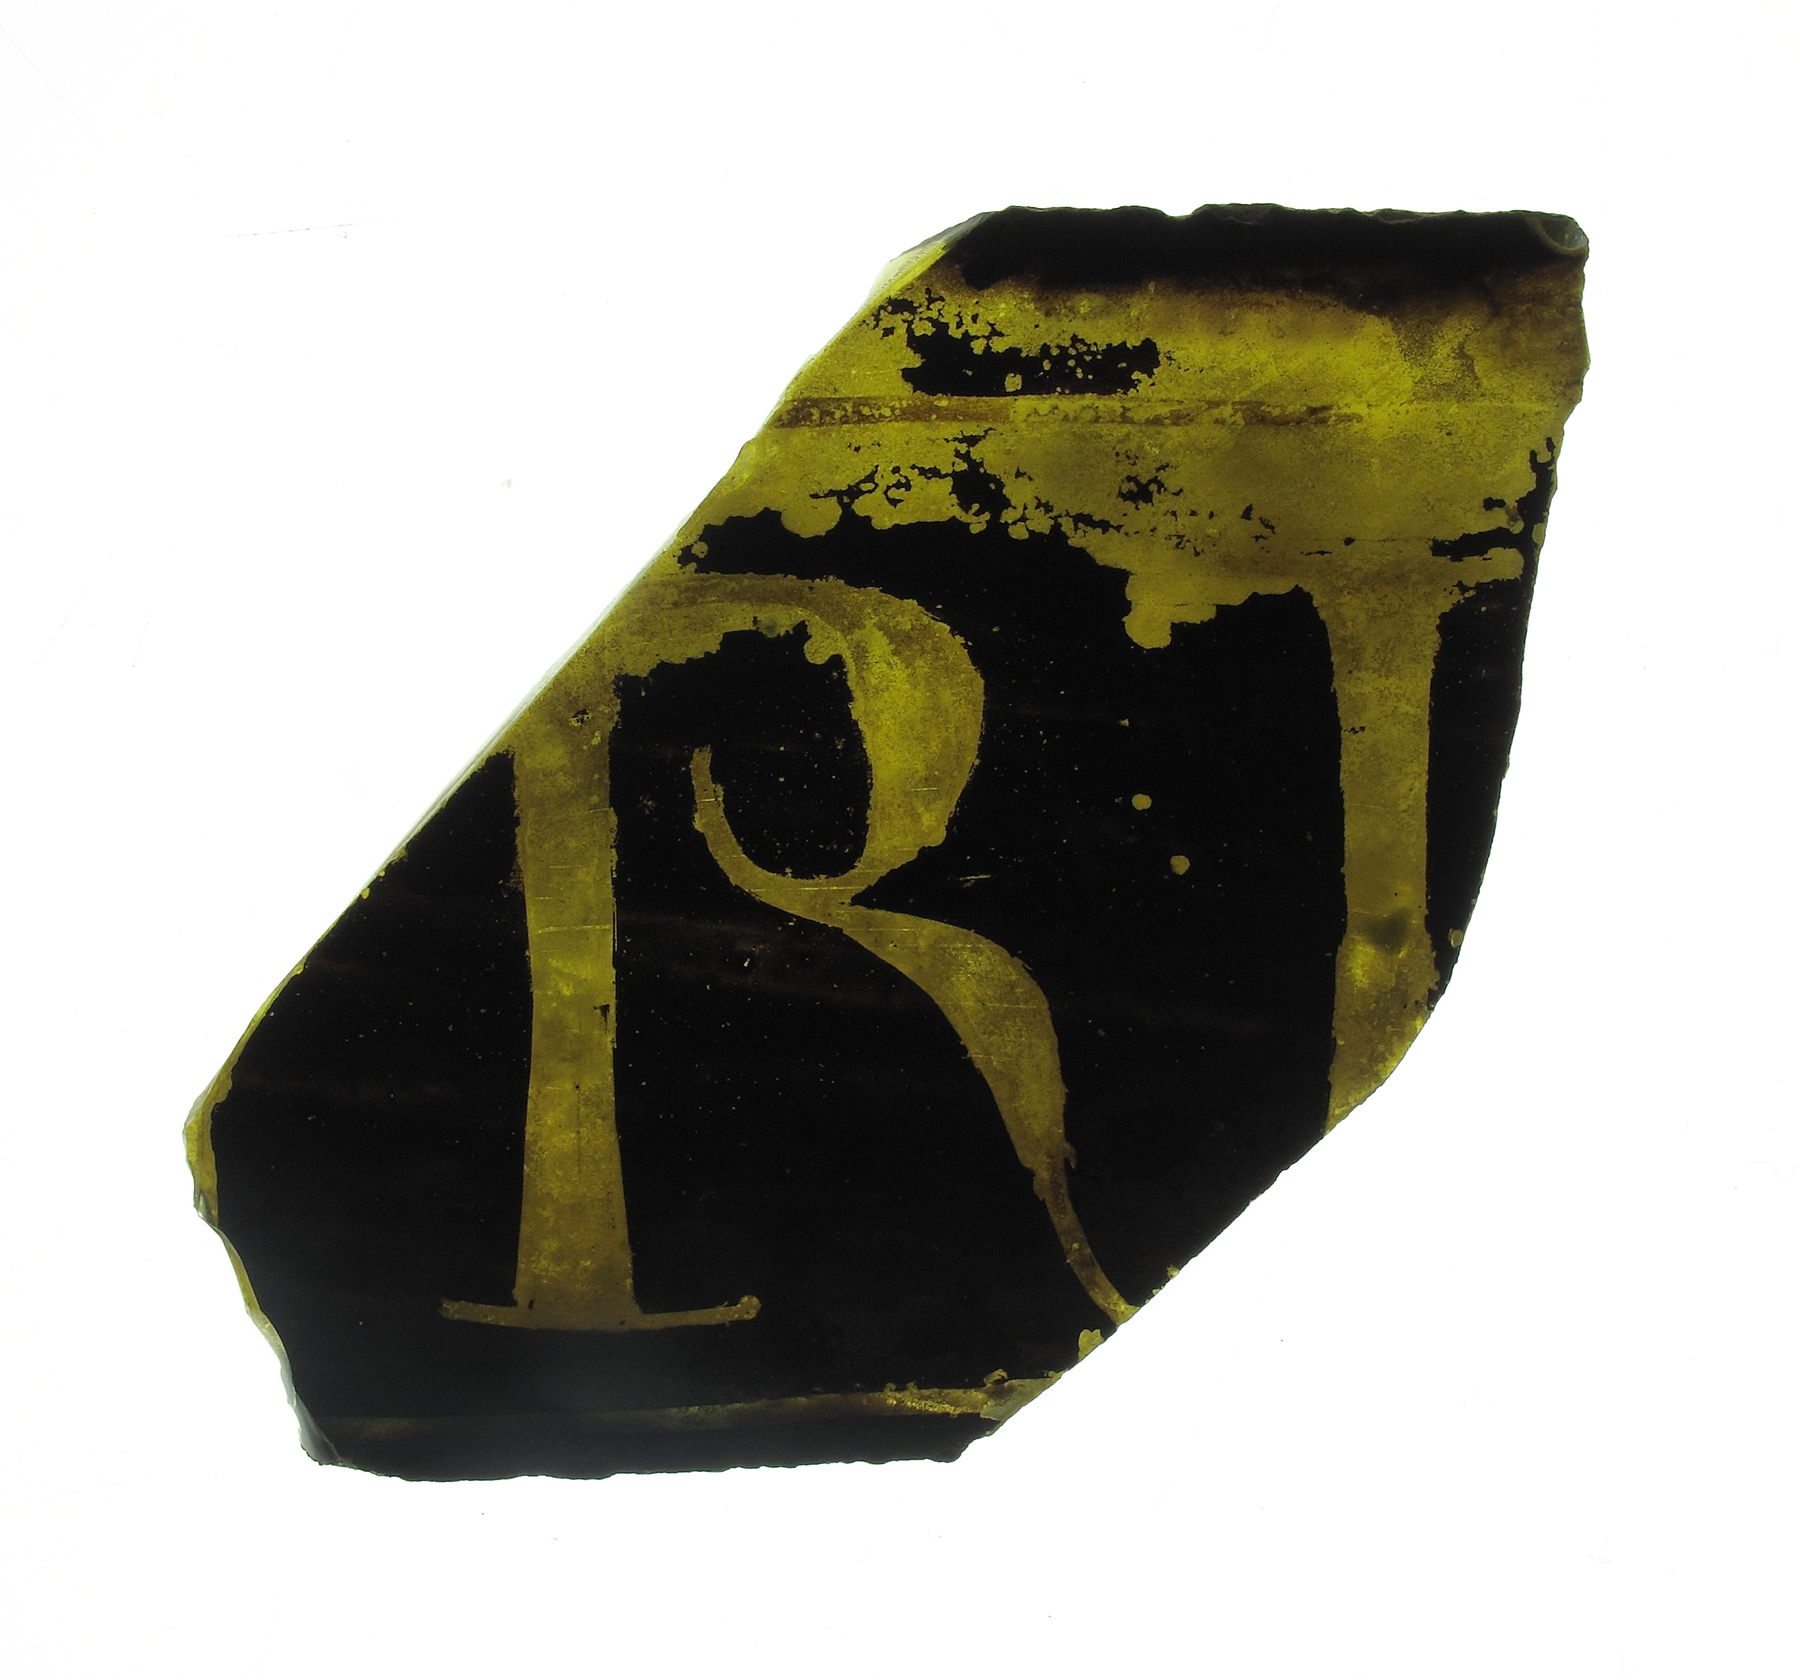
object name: fragment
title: Glass Fragment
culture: european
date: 1201-1300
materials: glass, metal